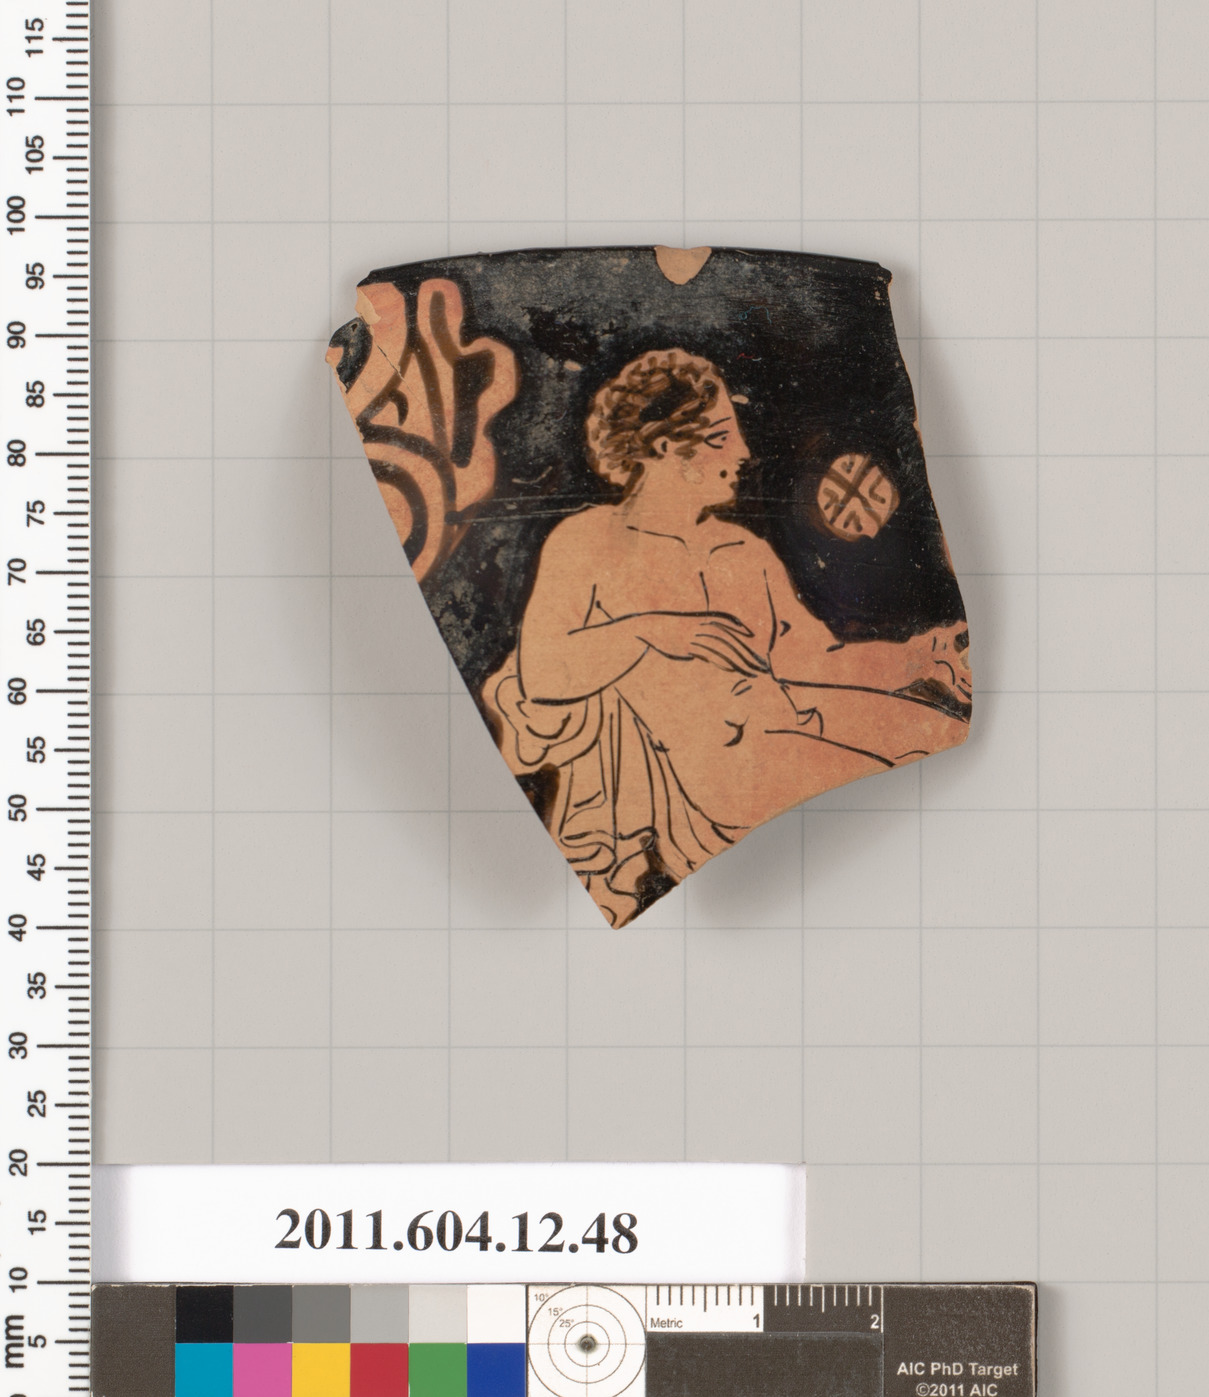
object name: skyphos fragment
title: Terracotta rim fragment of a skyphos (deep drinking cup)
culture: greek or south italian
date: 350-326 BCE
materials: terracotta